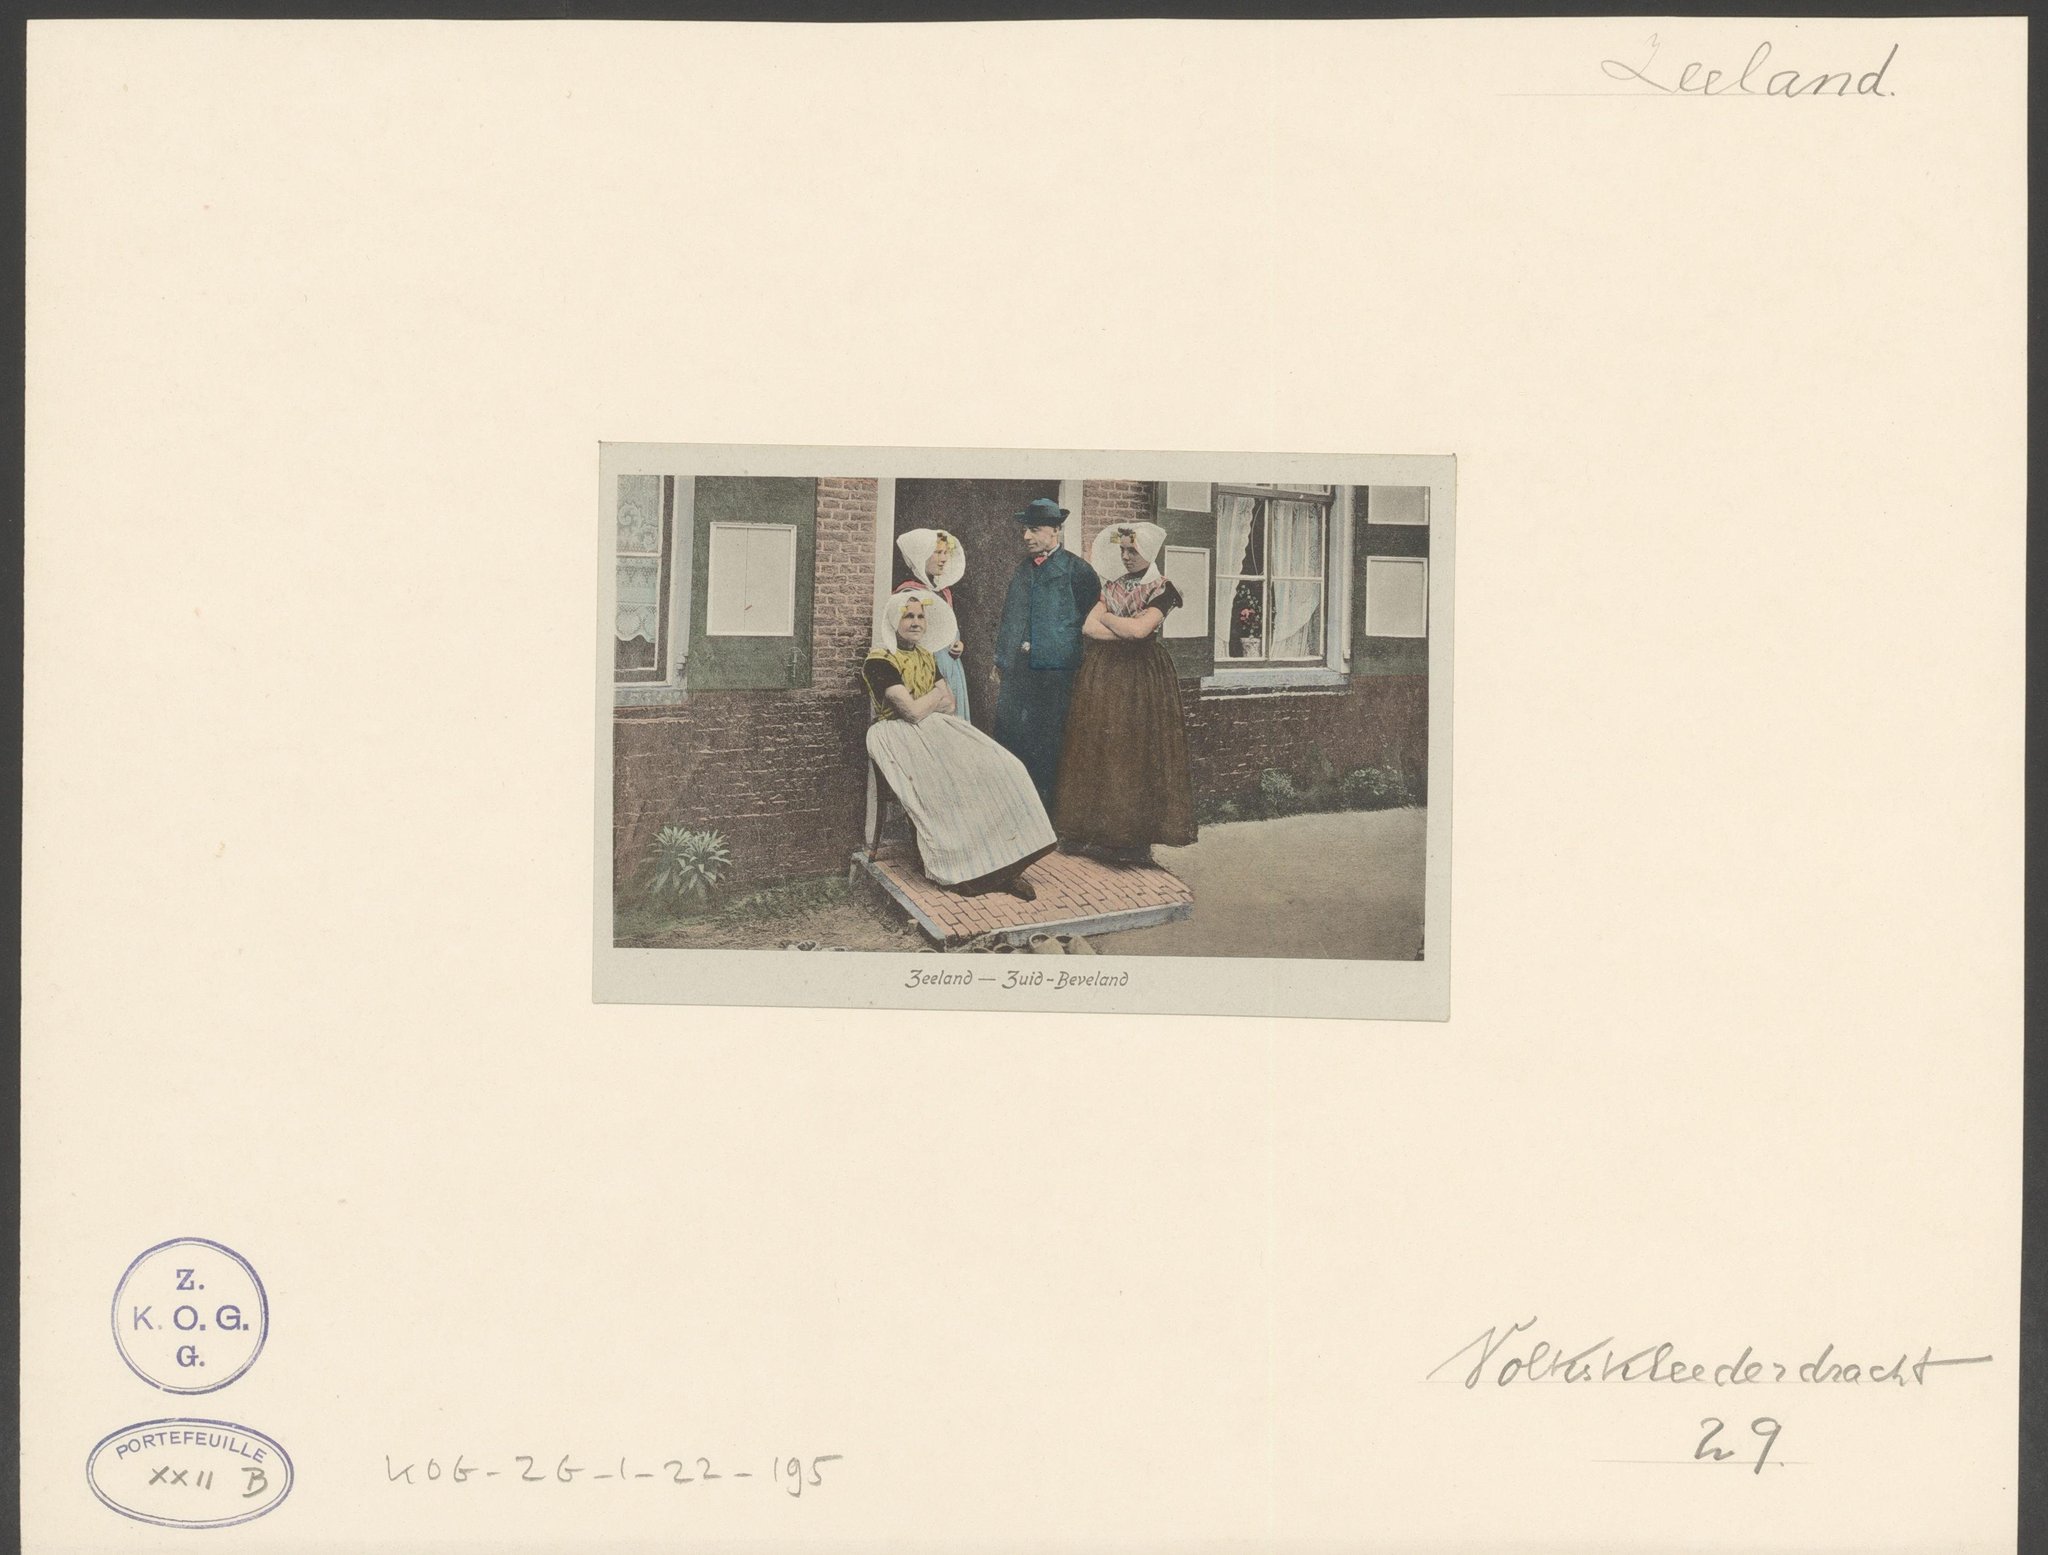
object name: photomechanical print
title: Zeeland - Zuid-Beveland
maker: Anonymous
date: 1905-1940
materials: paper, watercolor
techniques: photograph, hand coloring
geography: the hague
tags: clothes, costume (+ women's clothes), clothes, costume (+ men's clothes), folk costume, regional costume, zeeland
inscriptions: collector's mark, collector's mark: Lugt 1641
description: Drie vrouwen en een man bij de deur van een woning, in klederdracht van Zuid-Beveland. Onderwerpsrubrieken binnen de Atlas Zeden en Gewoonten: De Kleeding, Volkskleederdracht, Zeeland.